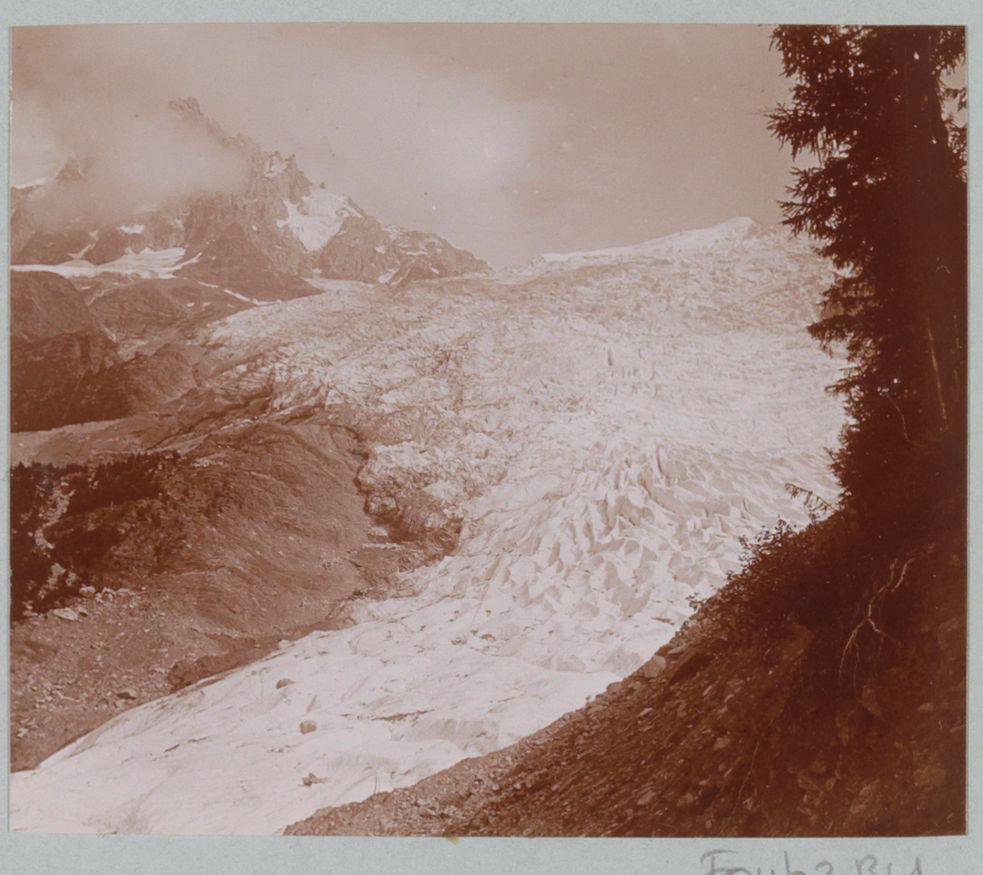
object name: photograph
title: Gezicht op een gletsjer in de Alpen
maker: Anonymous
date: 1905-1910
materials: paper, photographic support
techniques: gelatin silver print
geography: alps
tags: glacier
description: Onderdeel van Fotoalbum van een Franse amateurfotograaf met bezienswaardigheden in Frankrijk, Zwitserland en Italië.